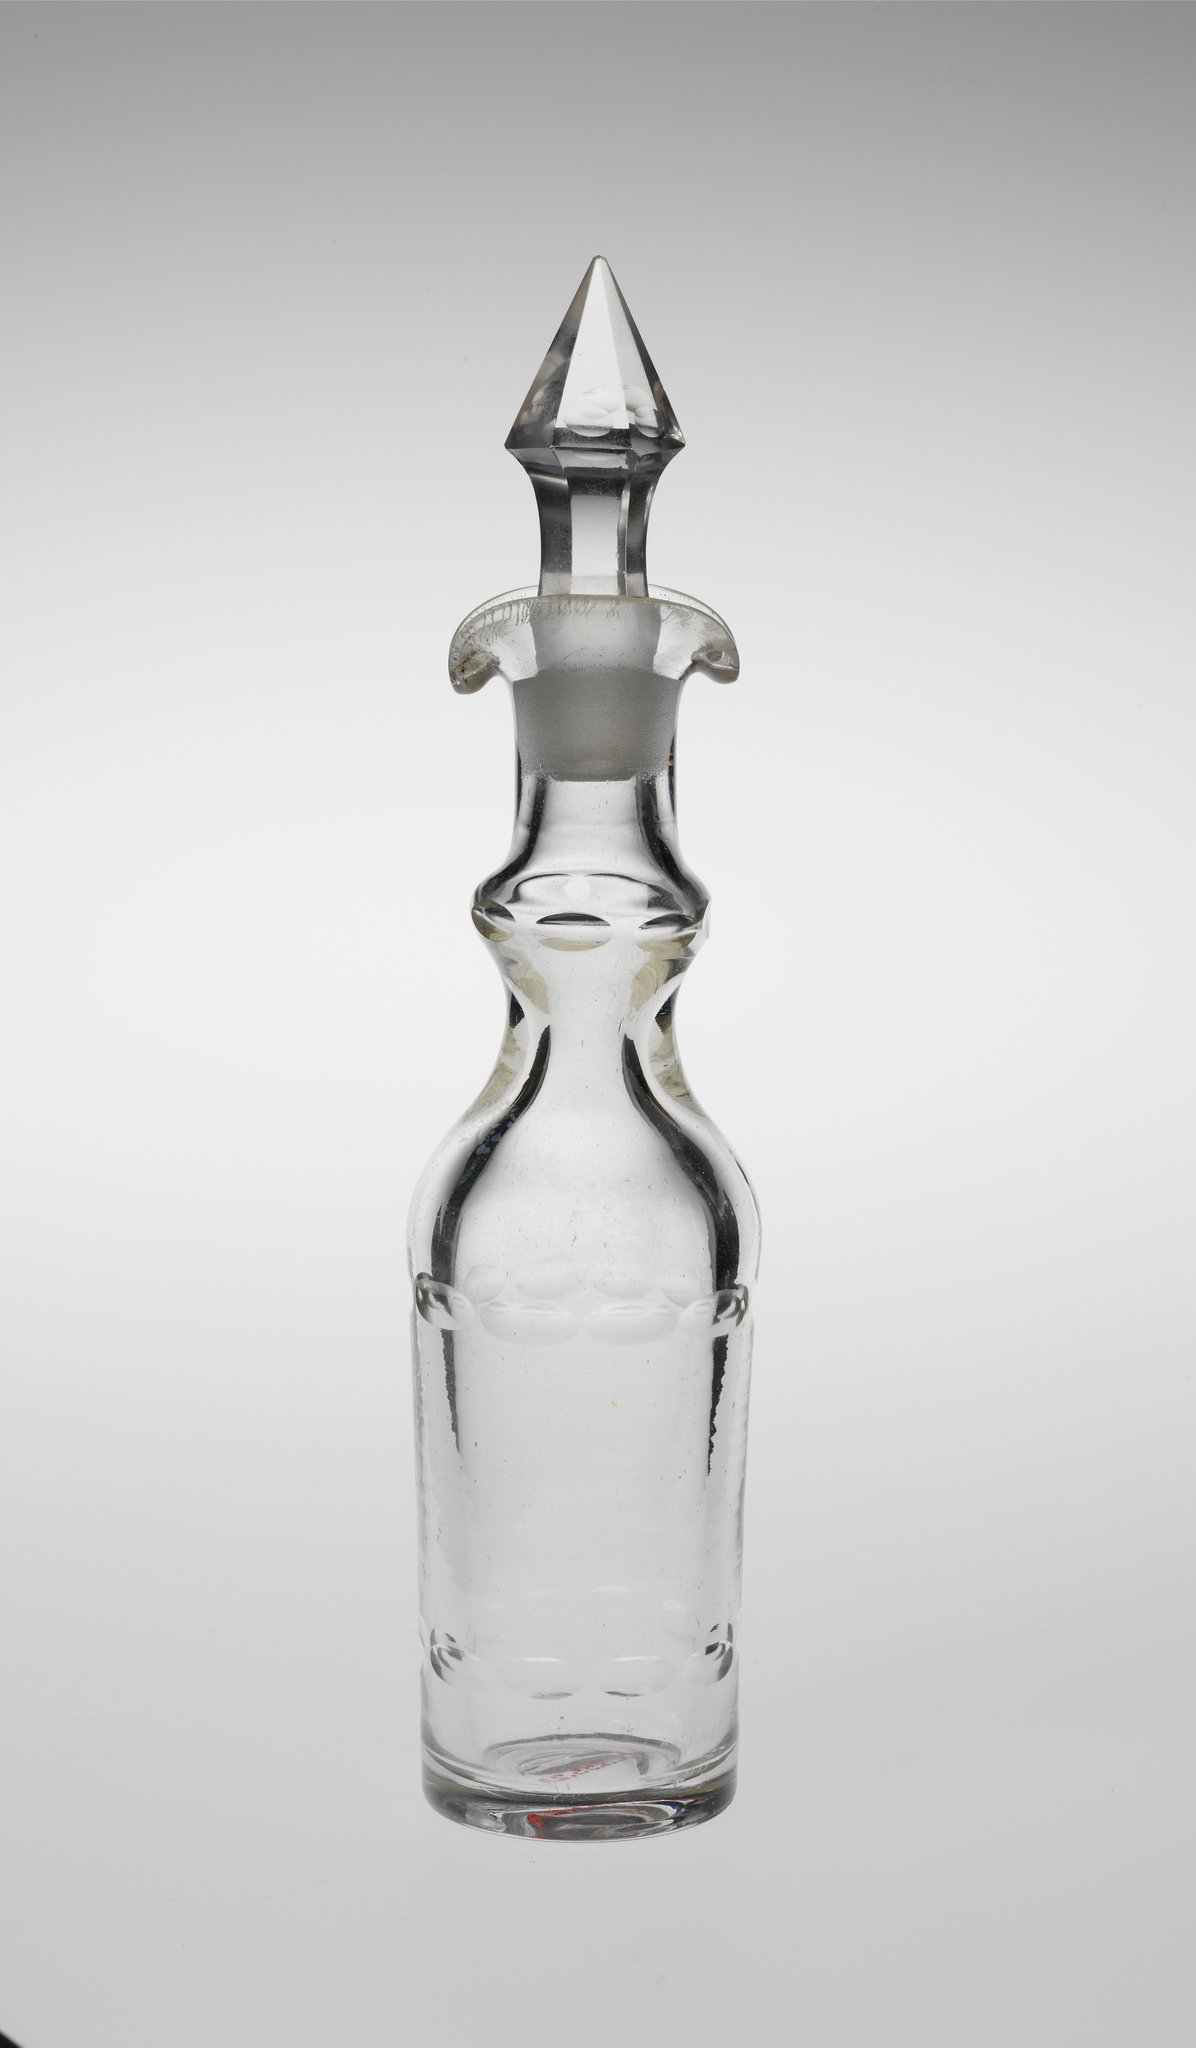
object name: bottle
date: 1700-1800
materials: glass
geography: ireland